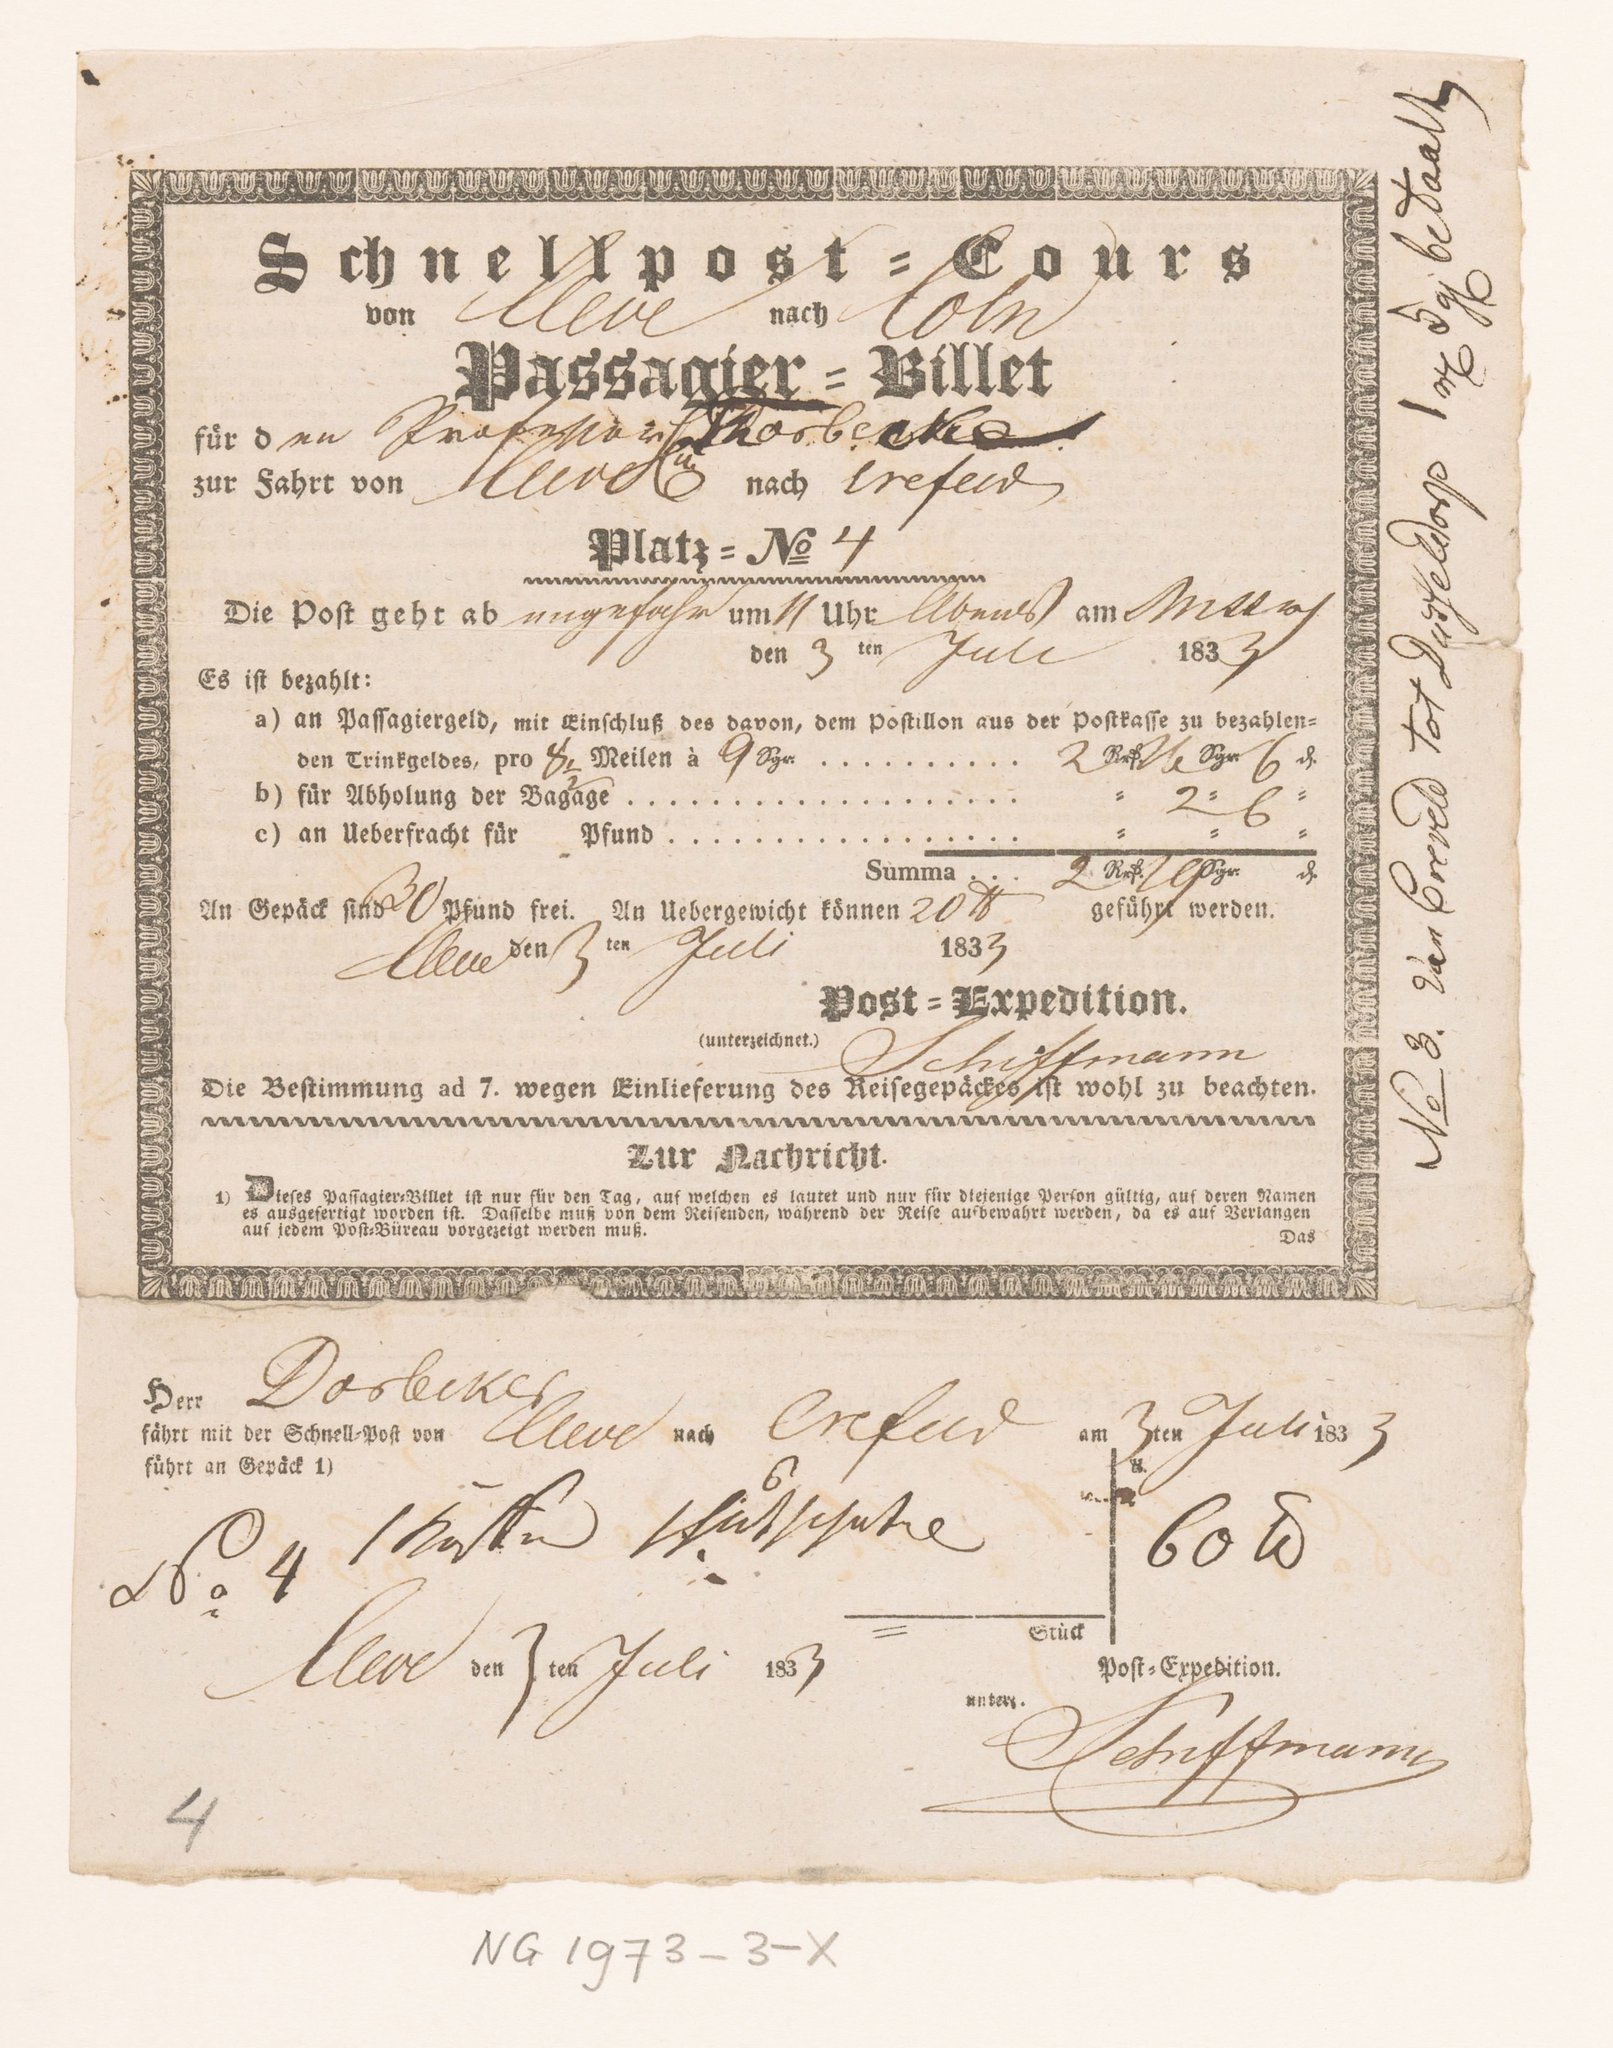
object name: travel document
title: Reisdocument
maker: Anonymous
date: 1833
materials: paper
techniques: printing, writing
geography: germany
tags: the hague, johan rudolf thorbecke, germany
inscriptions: date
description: Passagier-Billet Schnellpost Cours Kleve-Crefeld. Gedateerd: 3 juli. 1833.